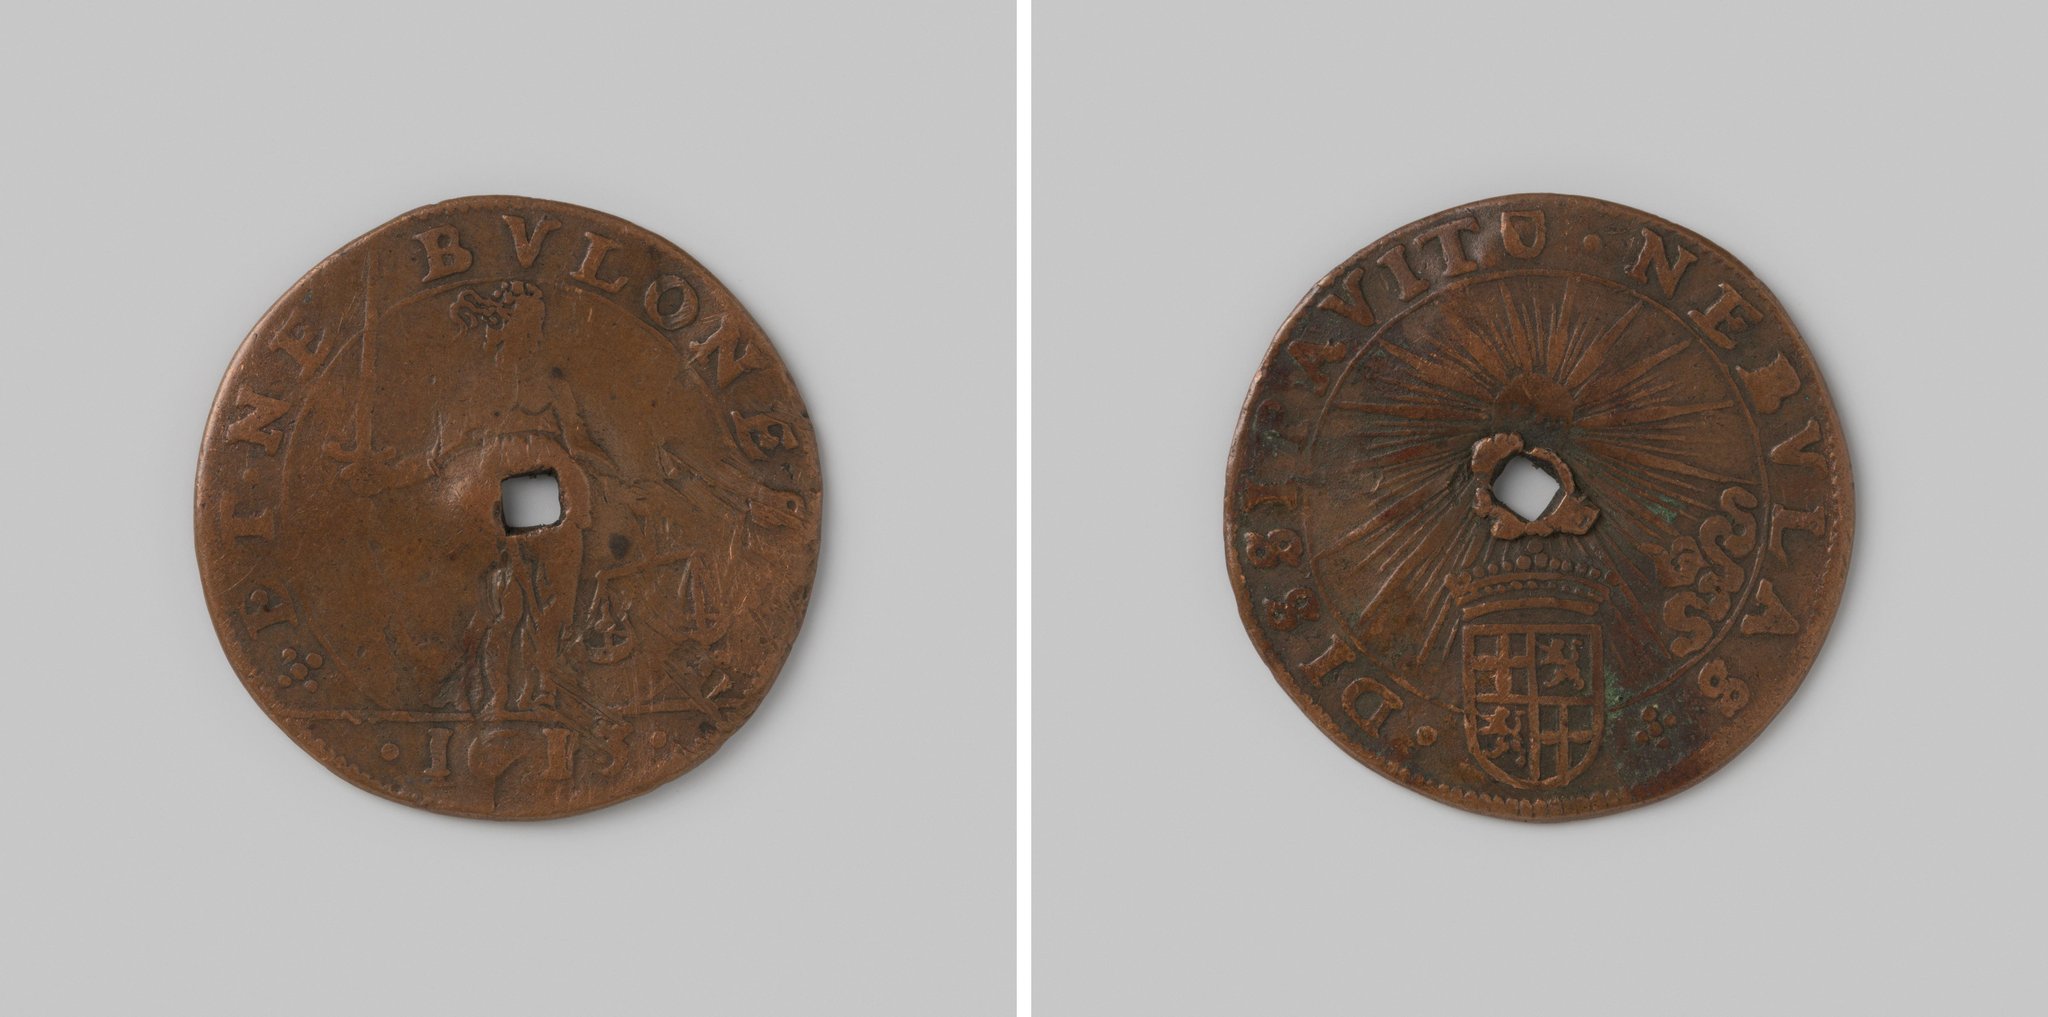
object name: history medal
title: Rekenpenning uit Utrecht op het herstel van de rust in Utrecht 1613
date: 1613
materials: copper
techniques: striking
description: Koperen penning met spijkergat, op de voorzijde Justitia met zwaard en weegschaal, met omschrift en afsnedetekst, op de keerzijde een stralende zon boven het gekroonde wapenschild van de provincie Utrecht, met omschrift.